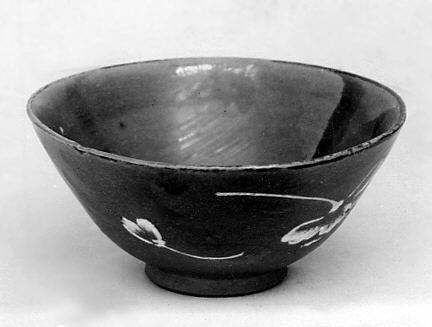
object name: bowl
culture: japanese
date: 1801-1900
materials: clay, glaze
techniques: inlay